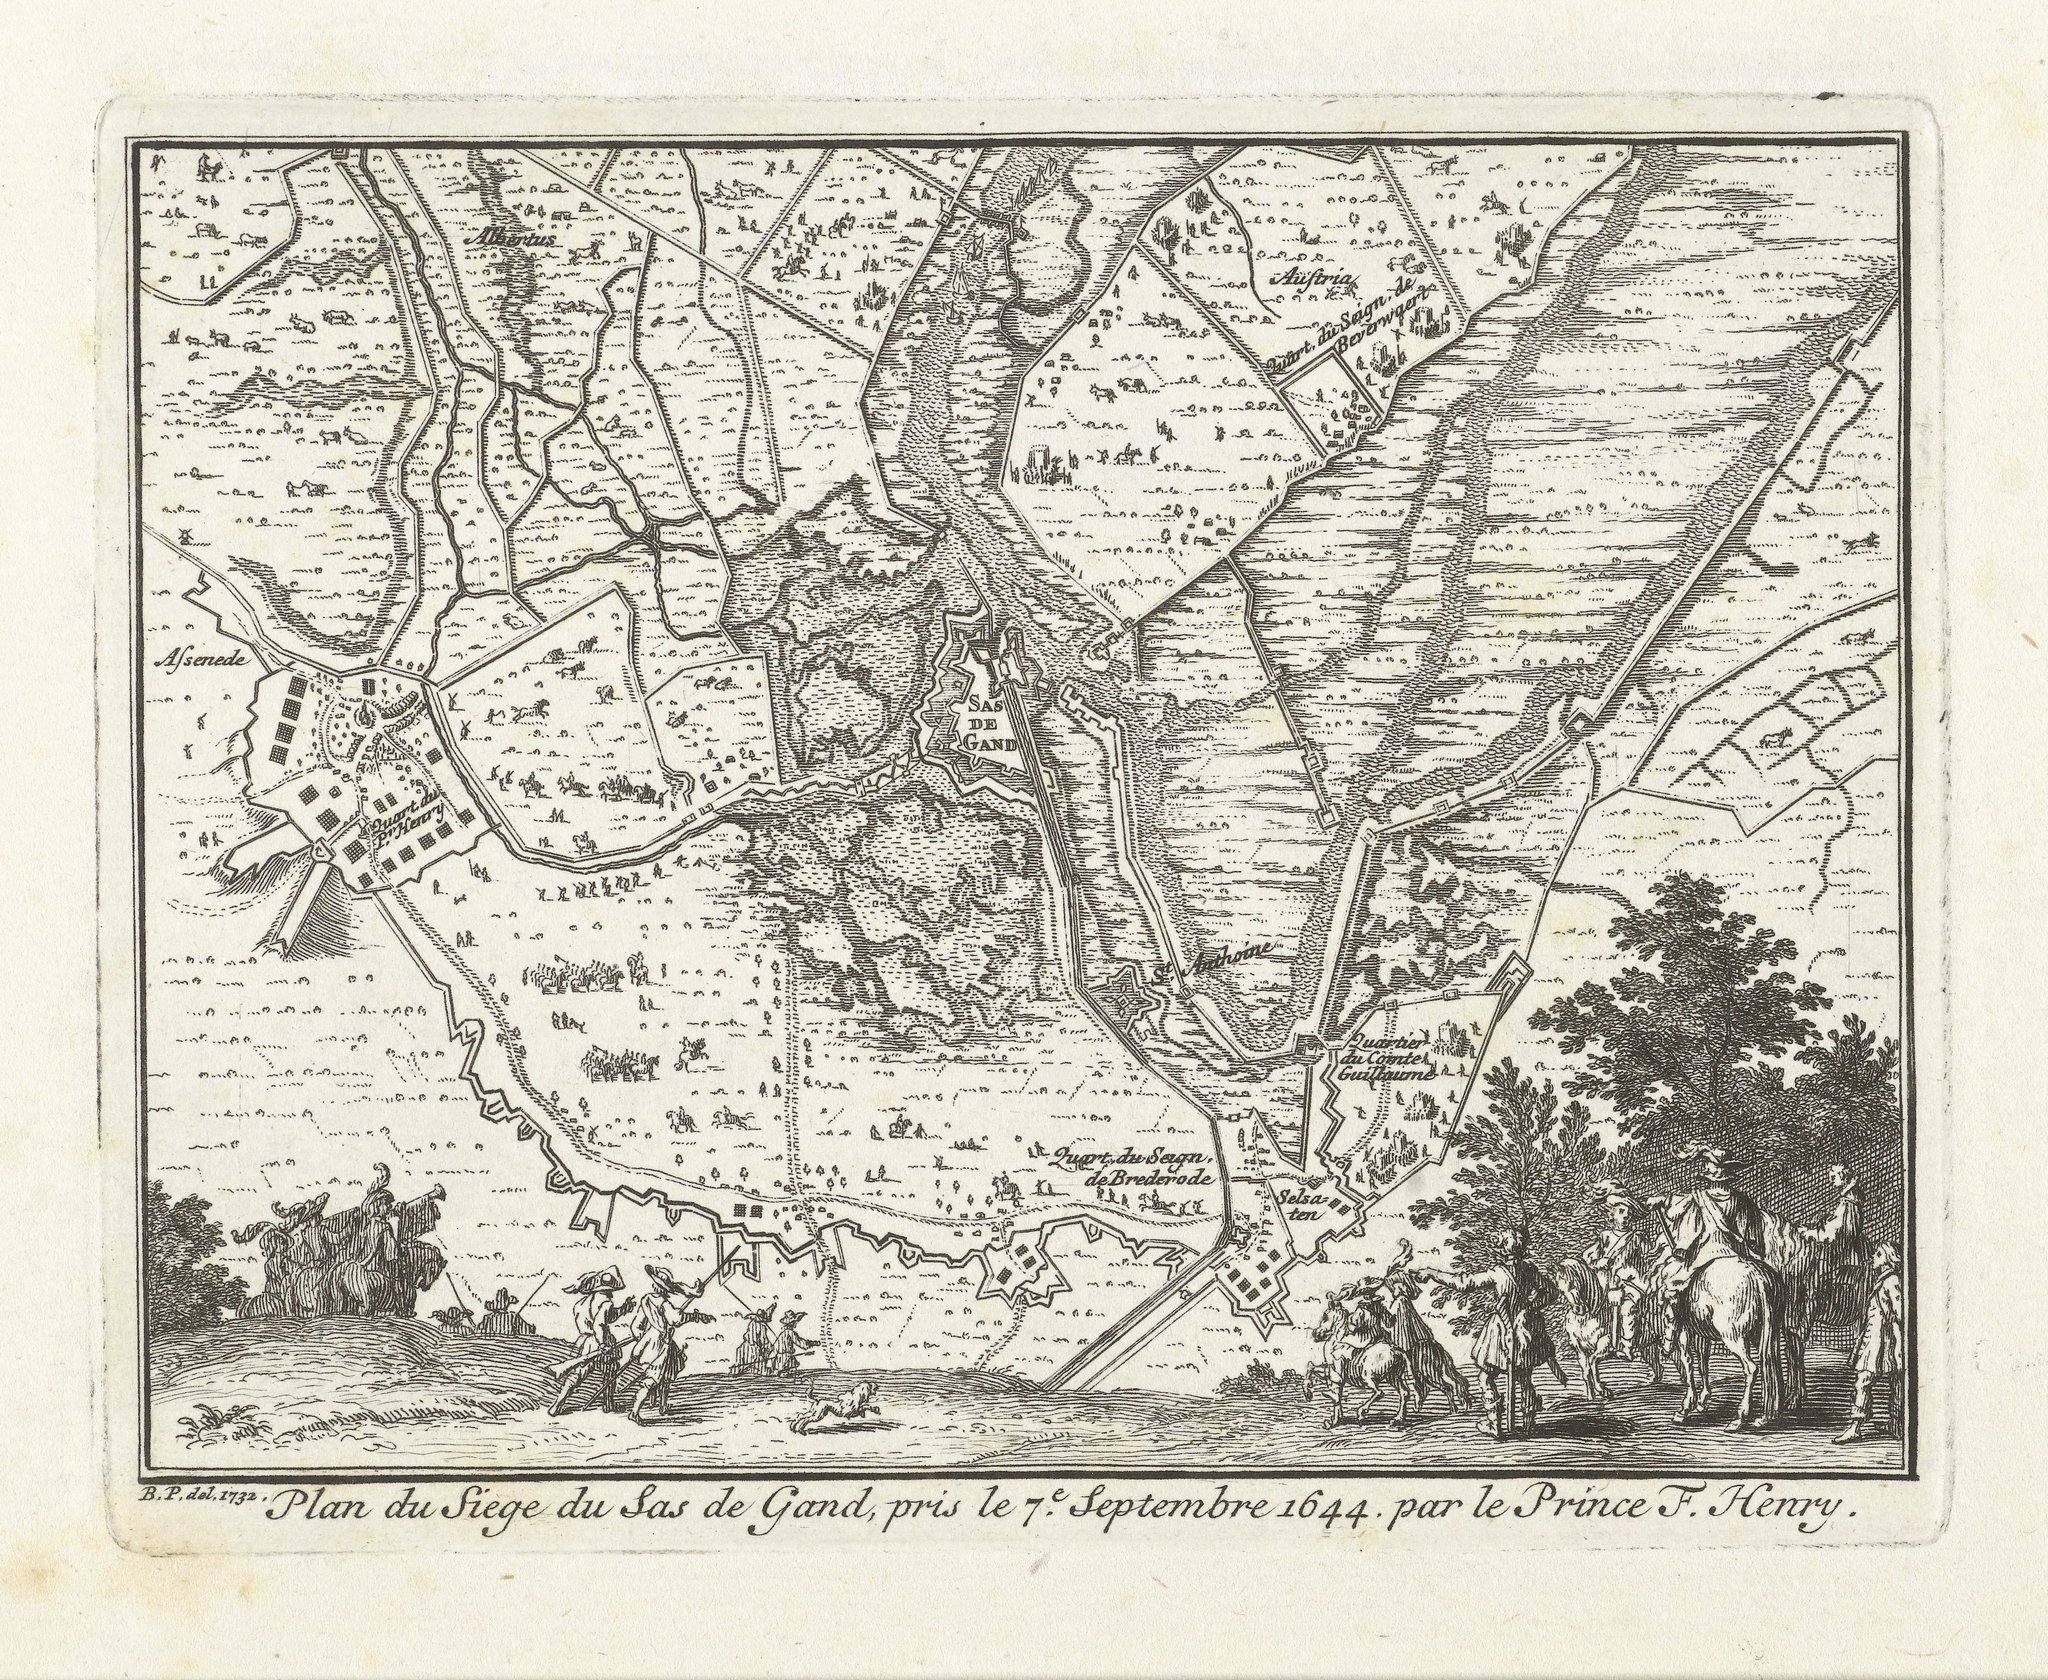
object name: print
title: Kaart van het beleg van Sas-van-Gent door Frederik Hendrik, 1629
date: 1732-1733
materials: paper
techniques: etching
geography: northern netherlands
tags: frederick henry (prince of orange), maps of separate countries or regions, siege, position war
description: Kaart van Sas-van Gent gedurende de omsingeling en het beleg door het Staatse leger onder Frederik Hendrik, 30 juli t/m 5 september 1644. Deze plaat samen met een andere plaat op één bladzijde gedrukt.